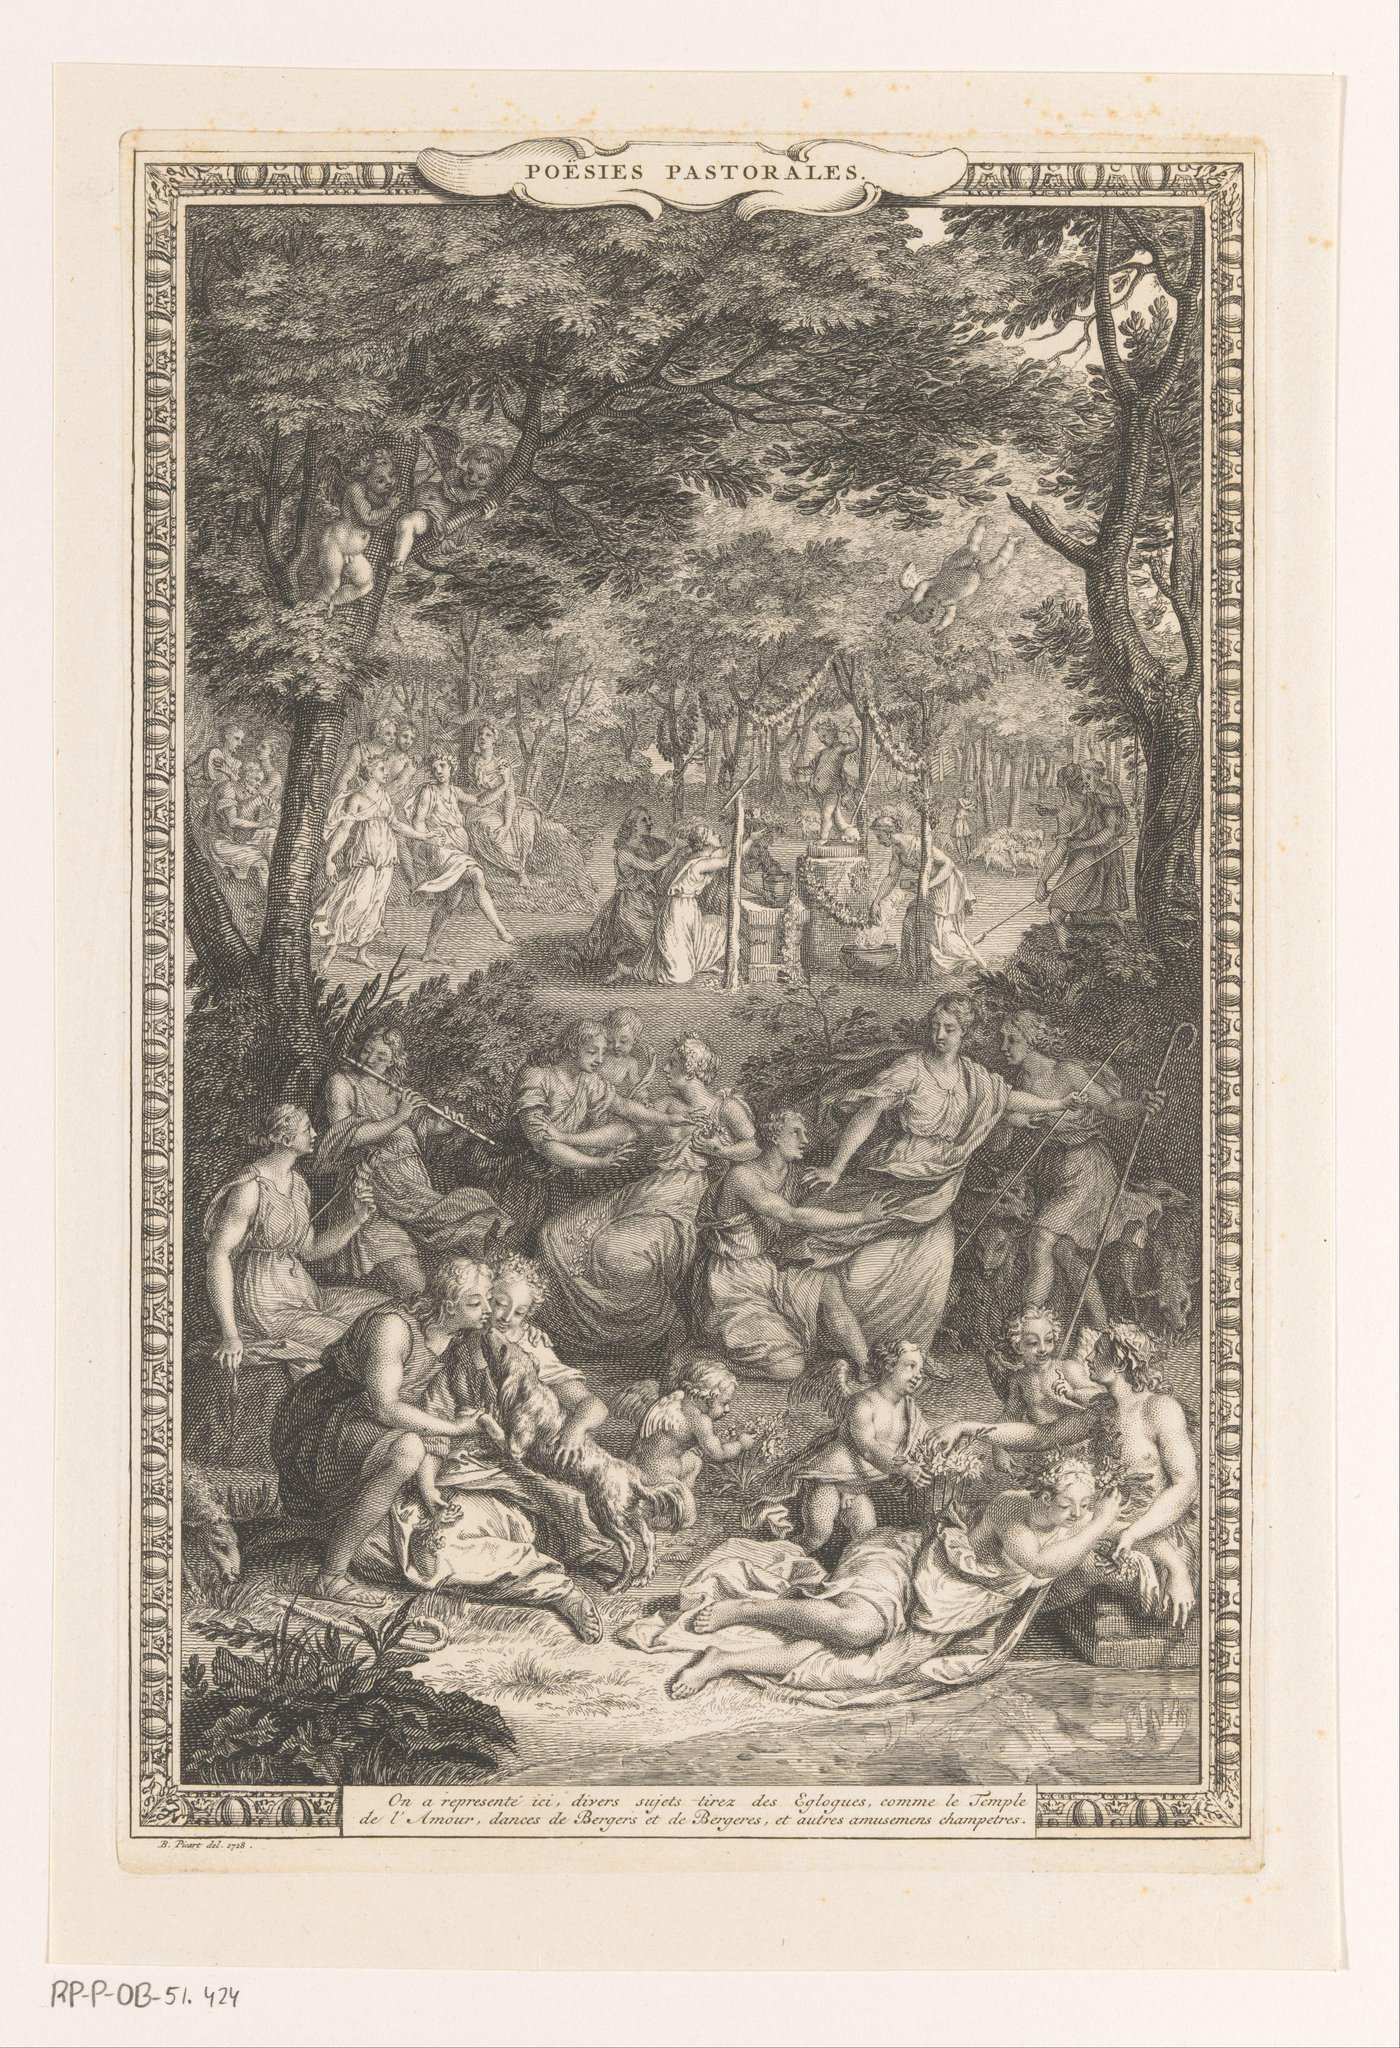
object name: book illustration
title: Allegorische voorstelling met herders en herderinnen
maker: bernard picart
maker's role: draughtsman, print maker, publisher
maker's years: 1673-1733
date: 1728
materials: paper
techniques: engraving, etching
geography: amsterdam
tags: making music; musician with instrument, (story of) cupid, amor (eros), group dancing, pastorals, arcadian scenes, sacrifice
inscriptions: collector's mark: Lugt 2228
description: Allegorische voorstelling met herders en herderinnen die zich in een bos vermaken. Op de voorgrond een vrouw die haar spiegelbeeld in het water bekijkt, een paar met een hond, herders en herderinnen die dansen en muziek maken. Op de achtergrond brengen vrouwen een offer aan Amor. In de marge een tweeregelig onderschrift in het Frans.